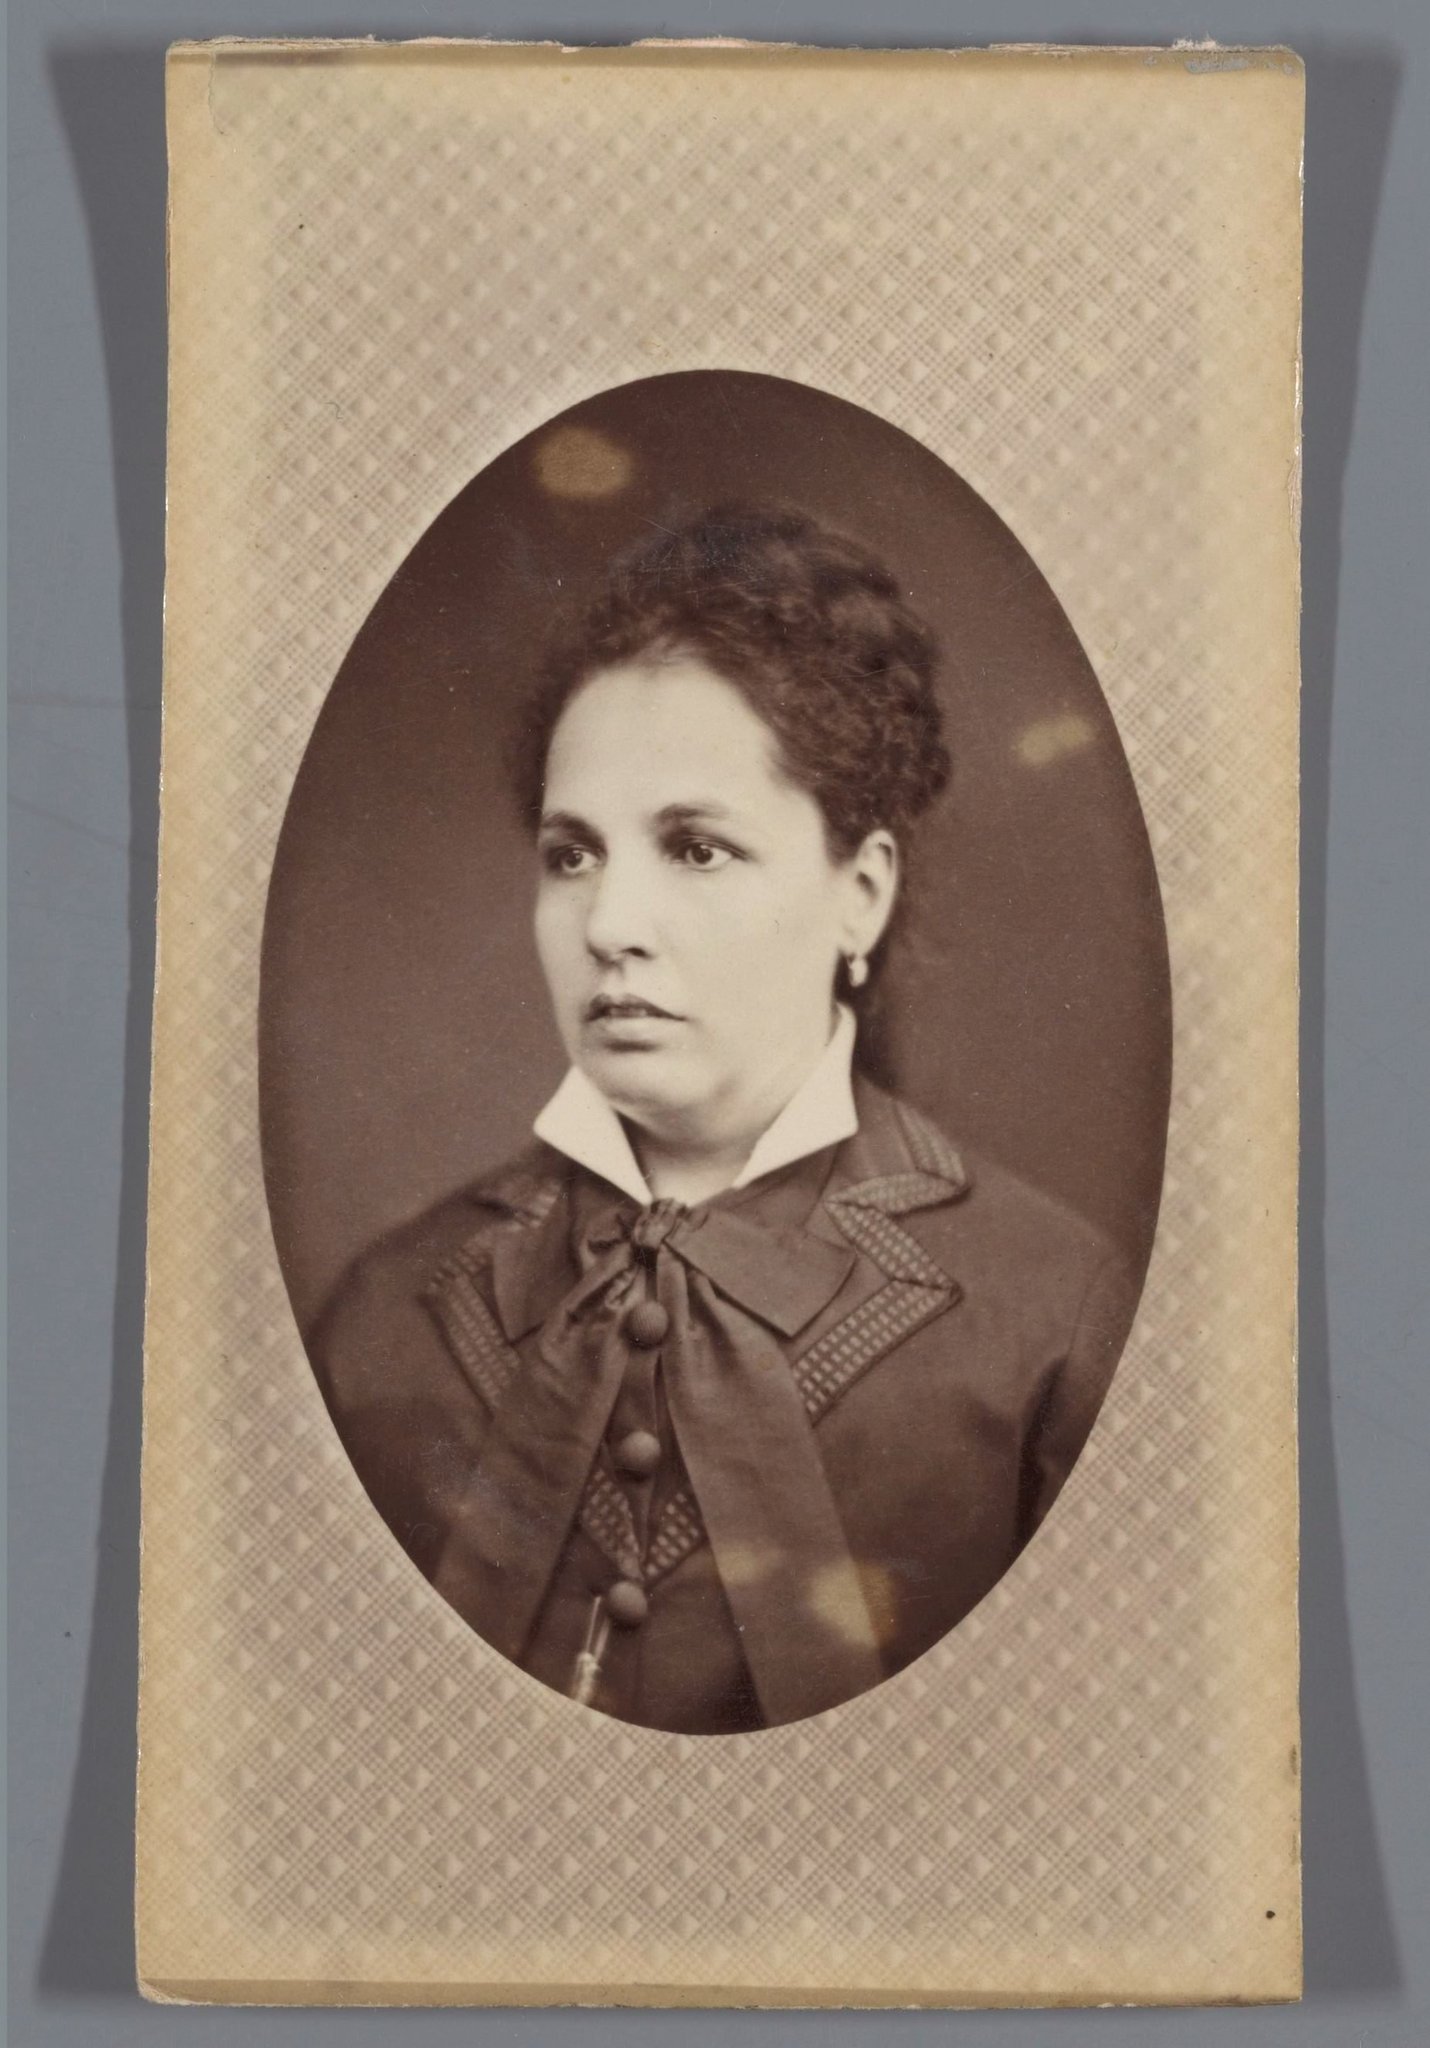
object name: photograph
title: Portret van een onbekende vrouw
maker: e. barracan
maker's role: fotograaf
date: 1880-1900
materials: cardboard, celluloid, paper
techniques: albumen print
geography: marseille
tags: historical persons - bb - woman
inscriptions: inscription: ‘PHOTOGRAPHIE INDUSTRIELLE/ Maison Spéciale/ d'AGRANDISSEMENTS/ PHOTOGRAPHIQUES/ E. BARRACAN/ 3/ Quai du Canal (Près le 1er Pont)/ MARSEILLE’